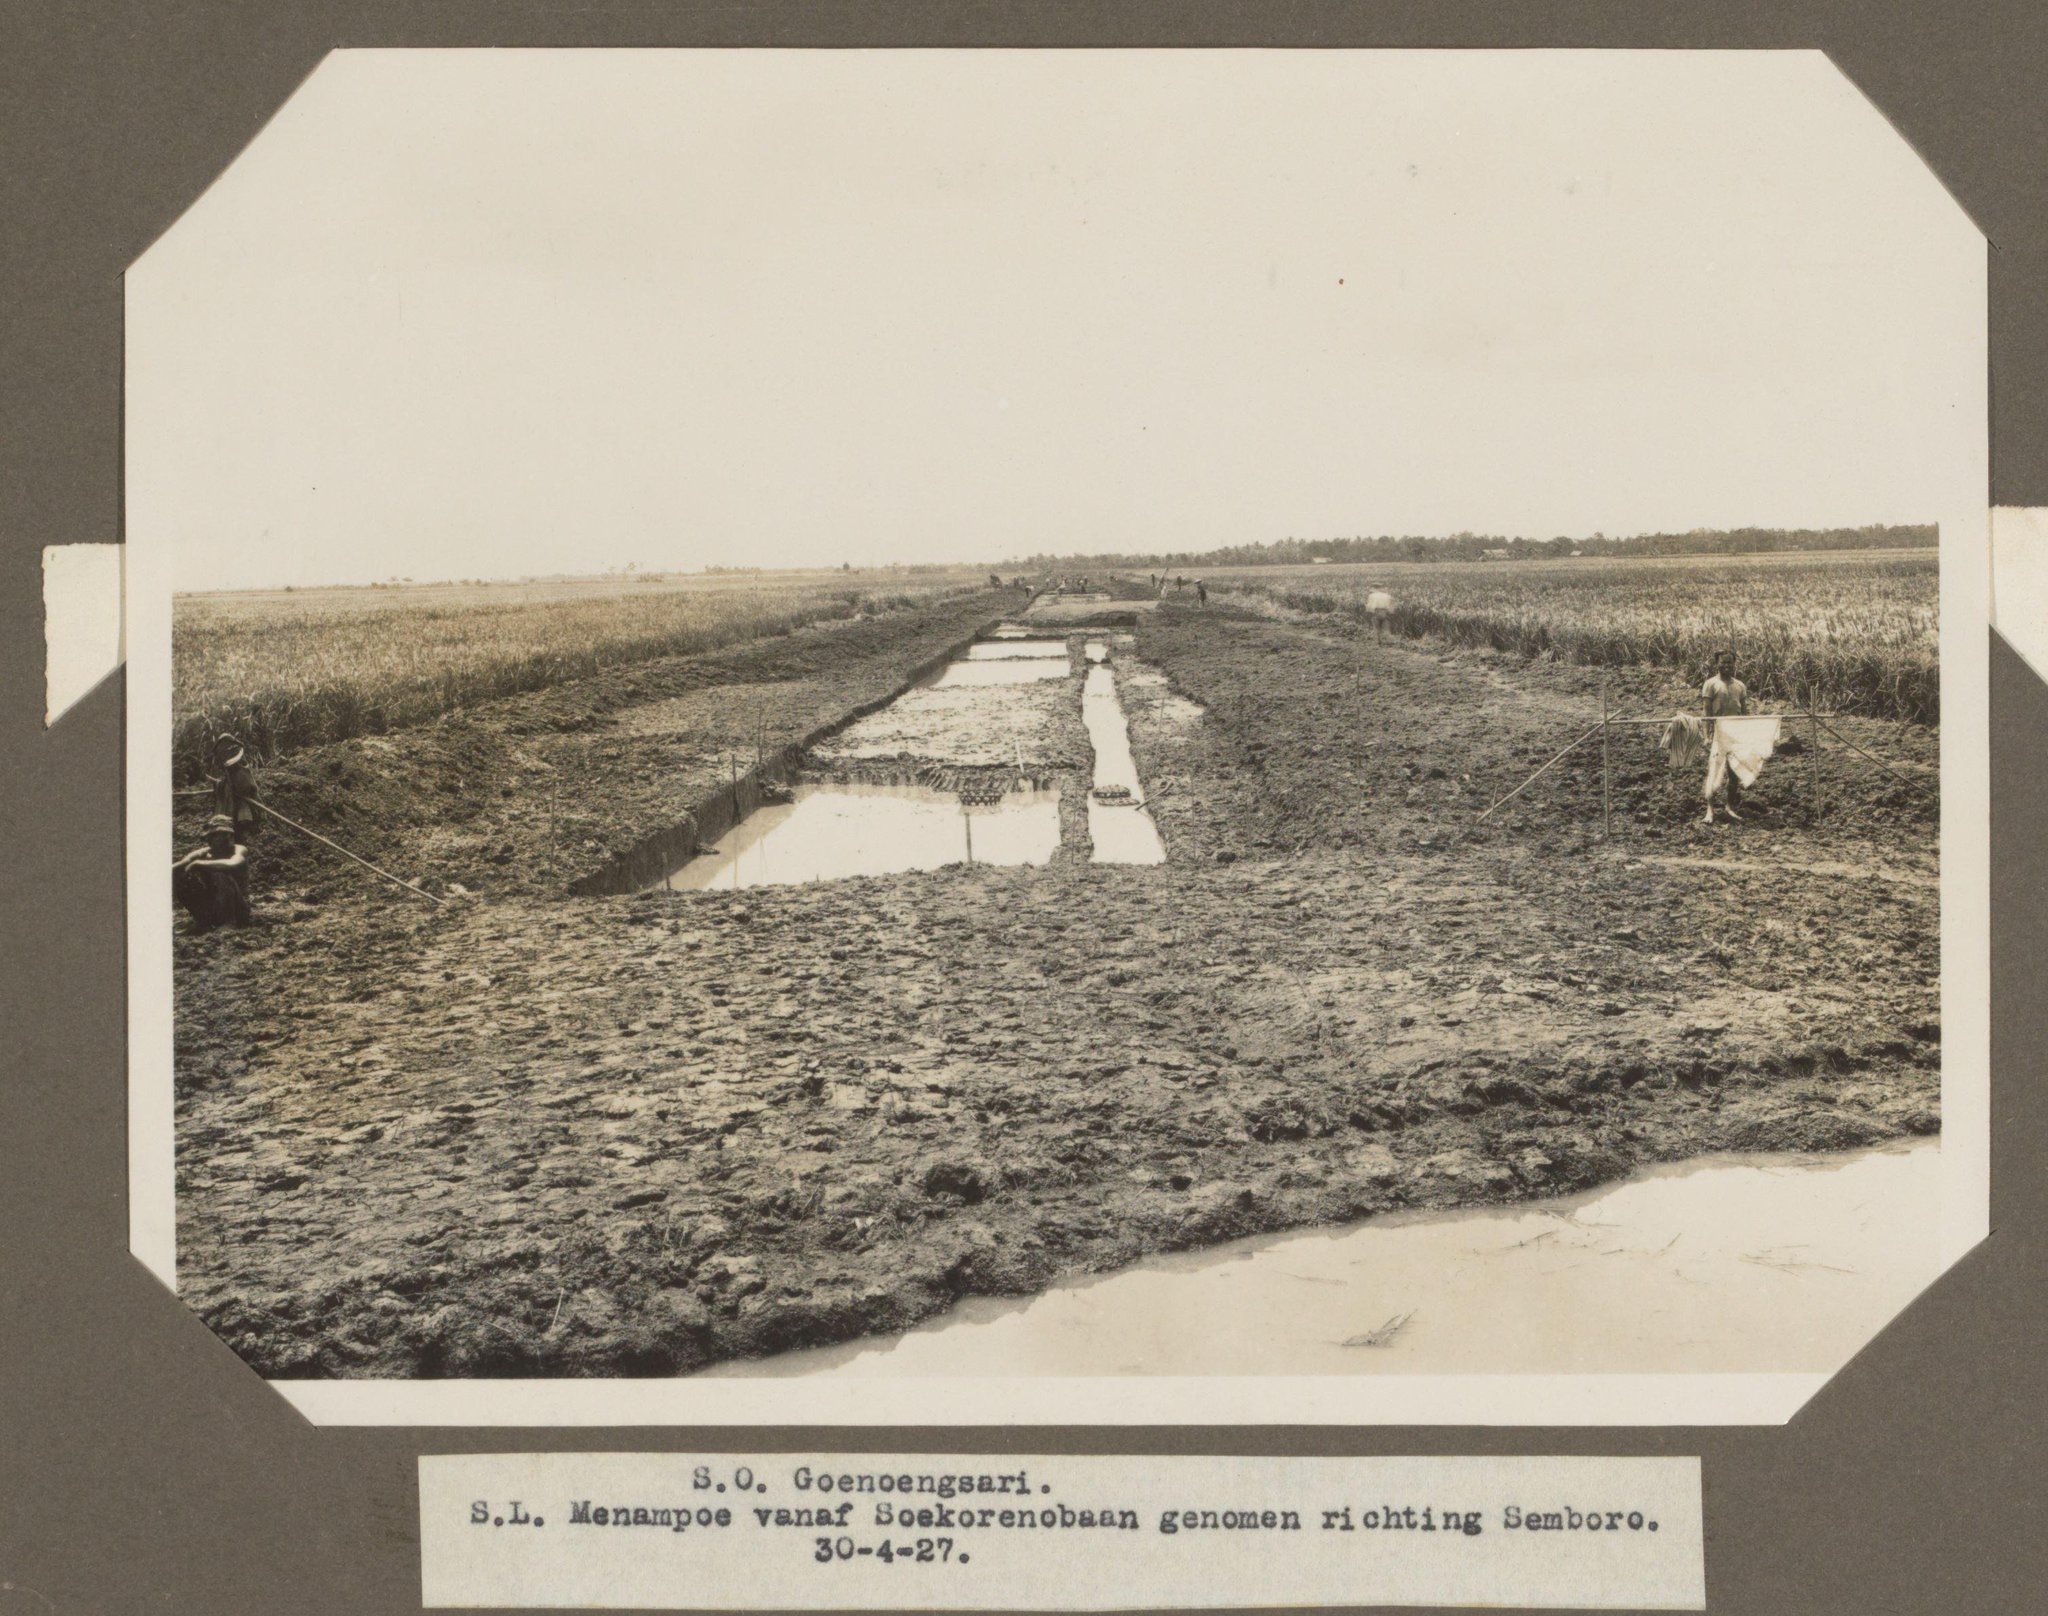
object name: photograph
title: S.O. Goenoengsari. S.L. Menampoe vanaf Soekorenobaan genomen richting Semboro. 30-4-27.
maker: Anonymous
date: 1904-1927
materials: photographic support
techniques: gelatin silver print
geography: east java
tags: colonial system, building activities, trade-company, (non-fruit) products of plants or trees: sugarcane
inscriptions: inscription: ‘S.O. Goenoengsari. S.L. Menampoe vanaf Soekorenobaan genomen richting Semboro. 30-4-27.’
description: Werkzaamheden aan de aan- en afvoerkanalen op het fabrieksterrein, april 1927. Onderdeel van het fotoalbum met foto's van de opbouw van de suikerfabriek te Goenoengsari op Oost-Java door de Handels Vereniging Amsterdam 1926-1927.